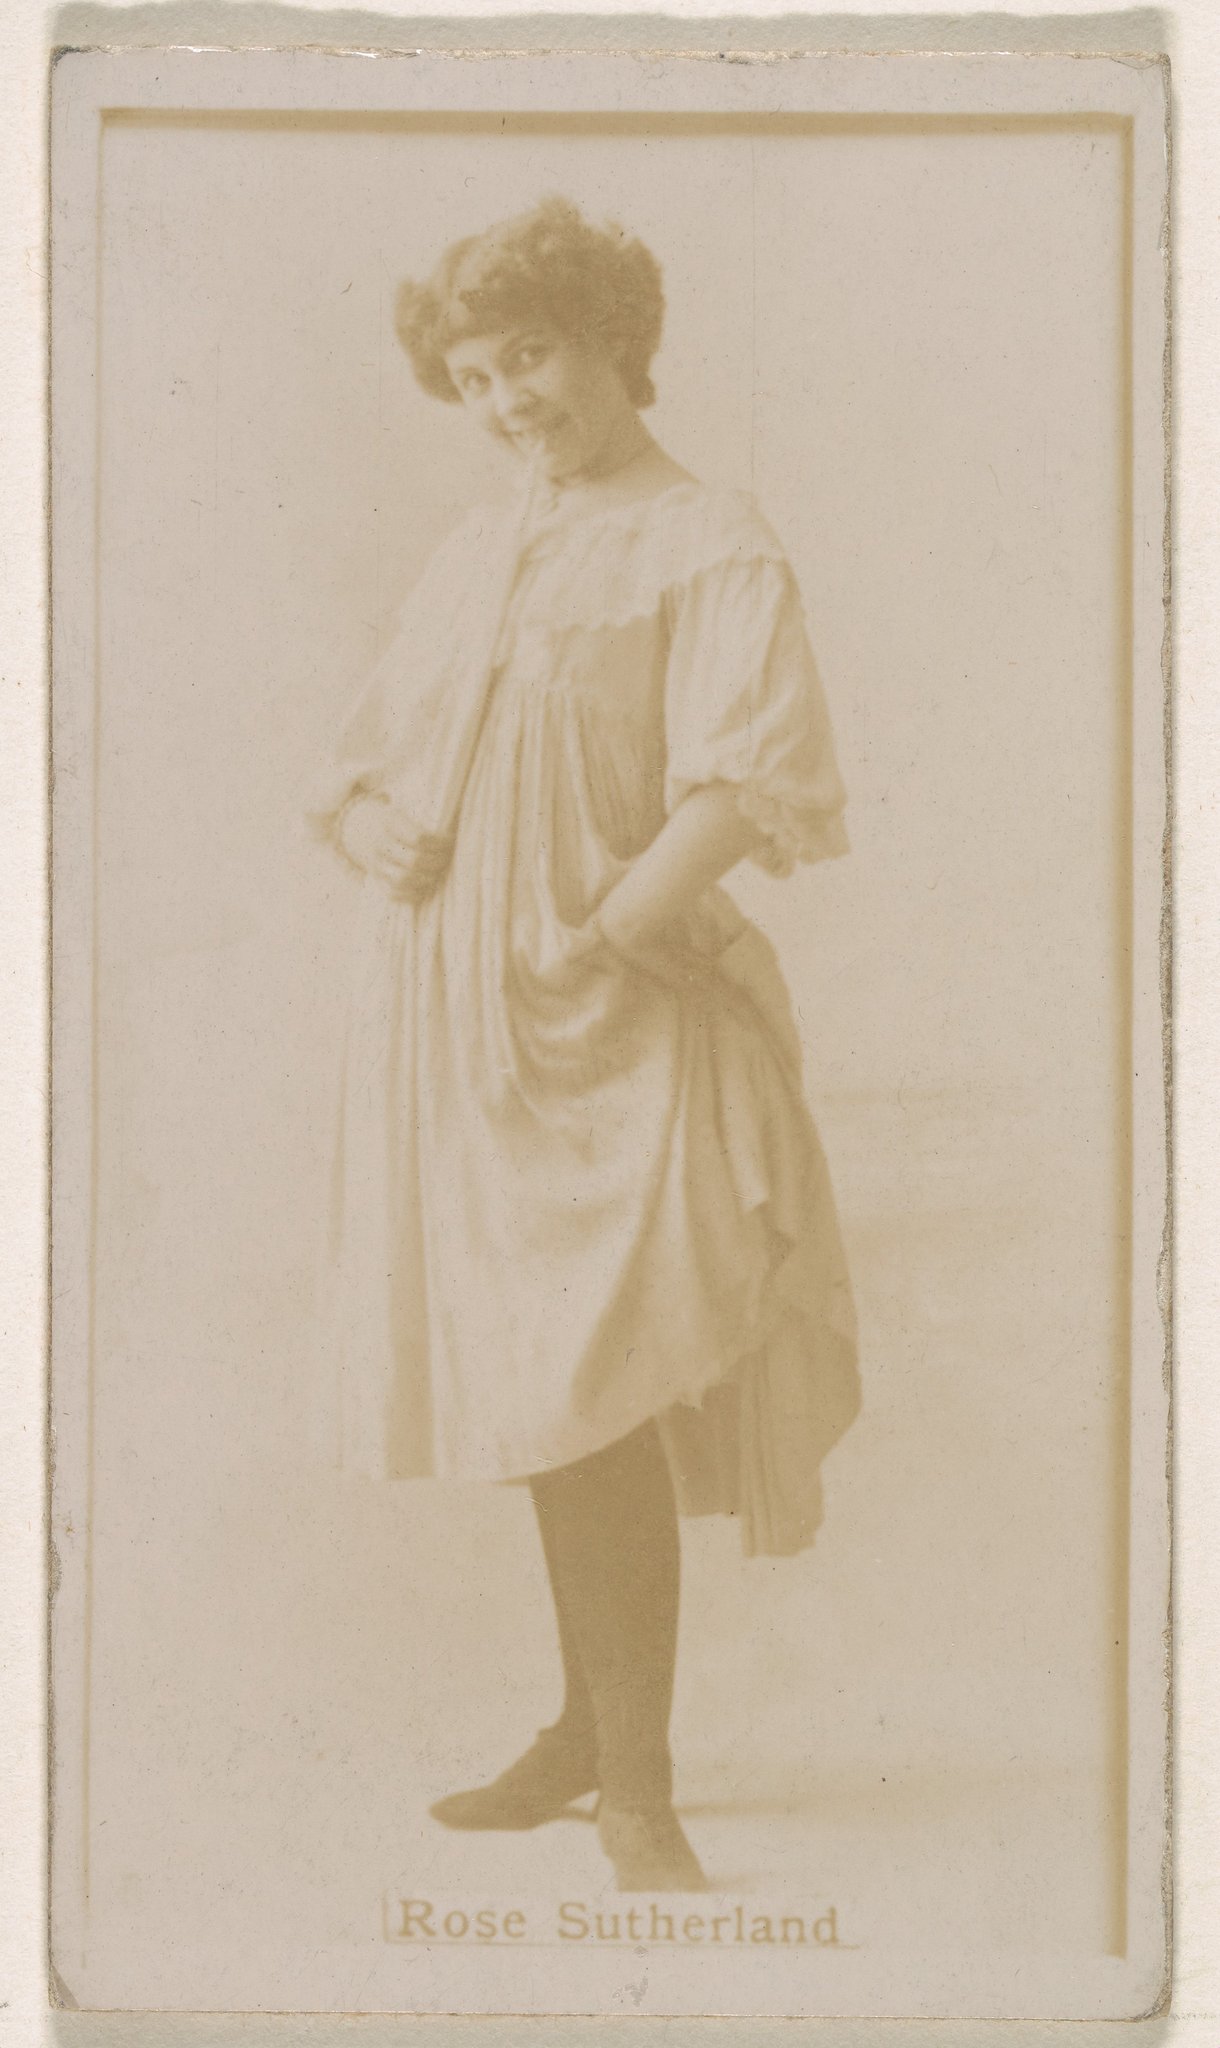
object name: photograph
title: Miss Rose Sutherland, from the Actresses series (N245) issued by Kinney Brothers to promote Sweet Caporal Cigarettes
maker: kinney brothers tobacco company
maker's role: publisher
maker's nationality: american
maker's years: 1869-2011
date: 1890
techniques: albumen silver print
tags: portraits,women,actresses